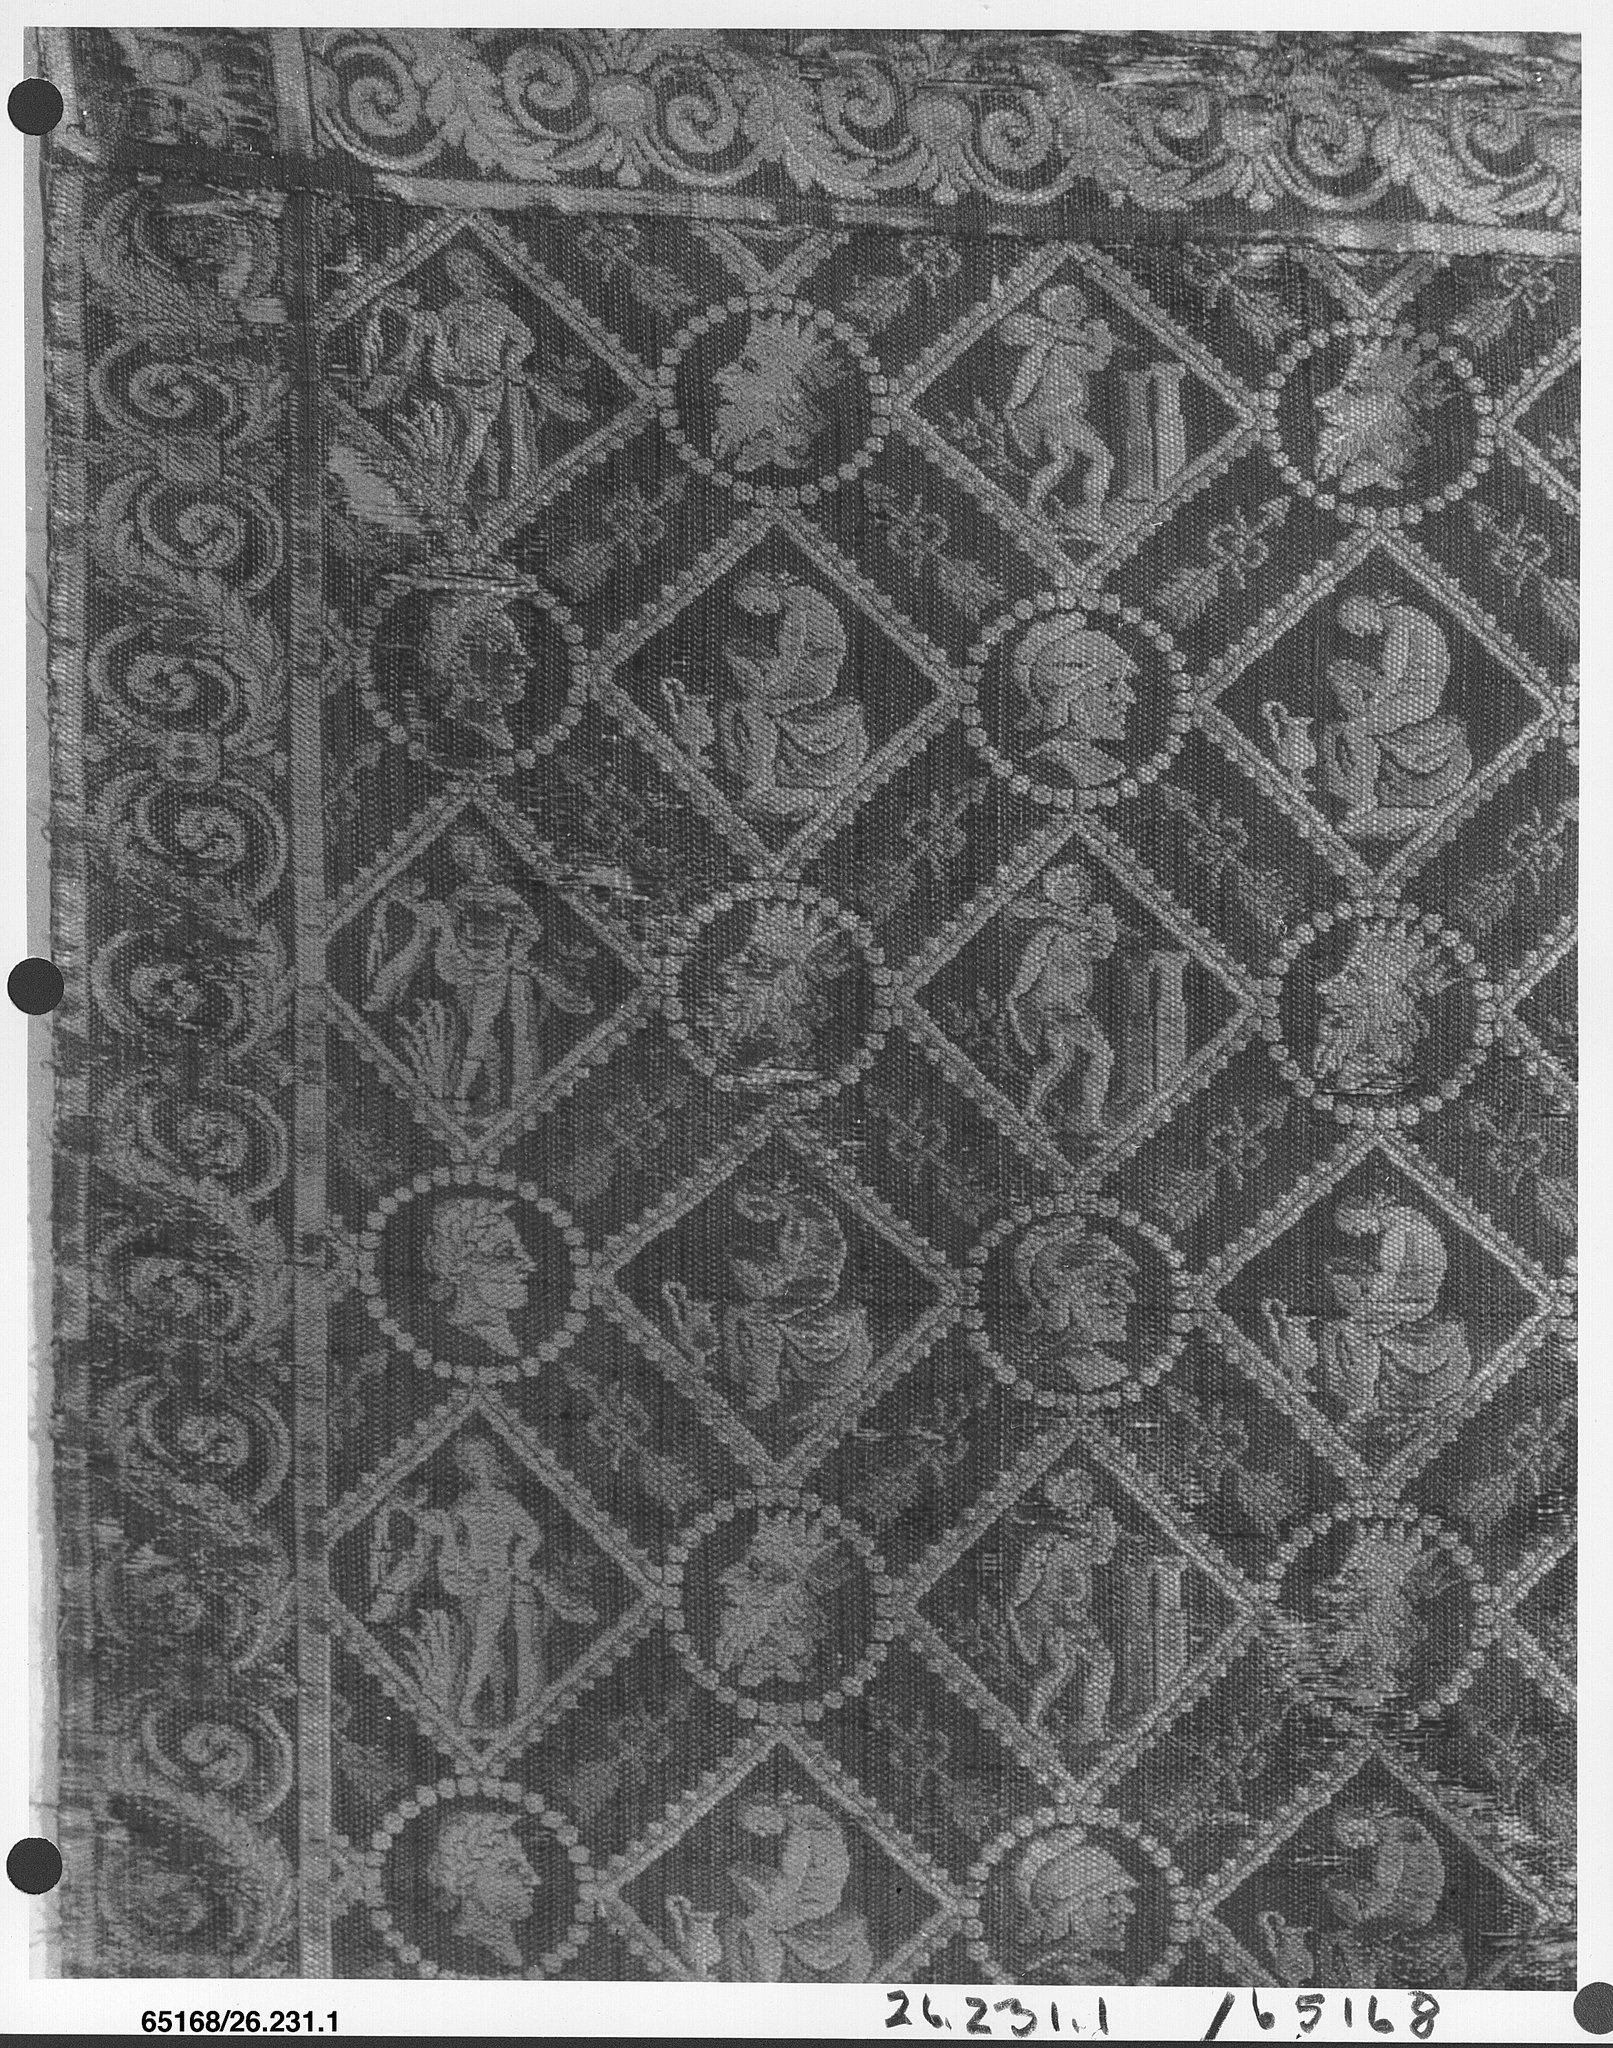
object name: panel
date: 1767-1833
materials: silk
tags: men,profiles